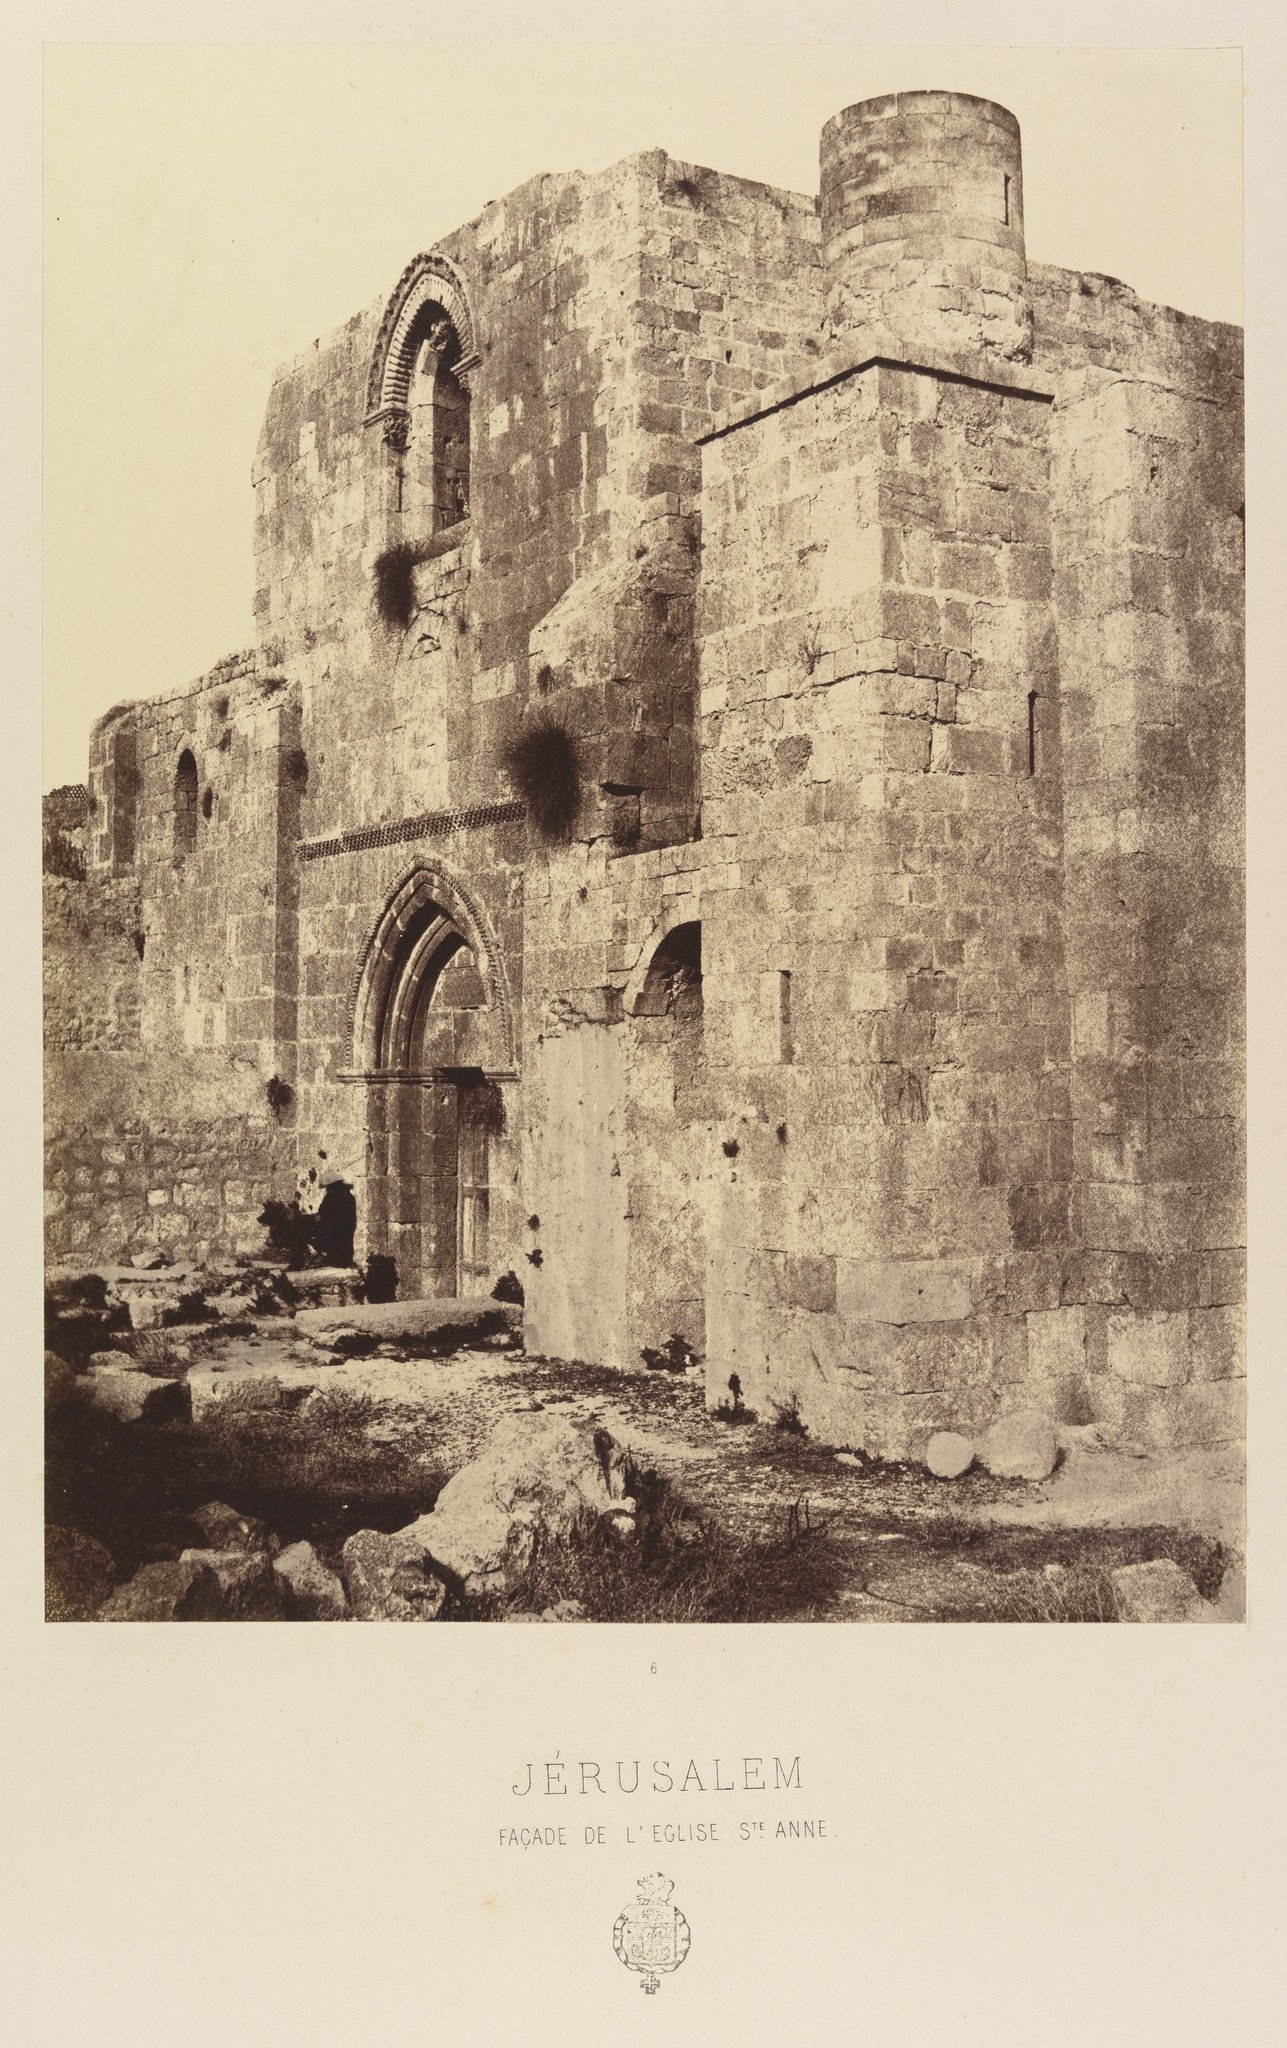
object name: photograph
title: Jérusalem. Façade de l'Église Ste. Anne.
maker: louis de clercq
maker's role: artist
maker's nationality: french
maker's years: 1837-1901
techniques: albumen silver print, paper negative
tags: churches